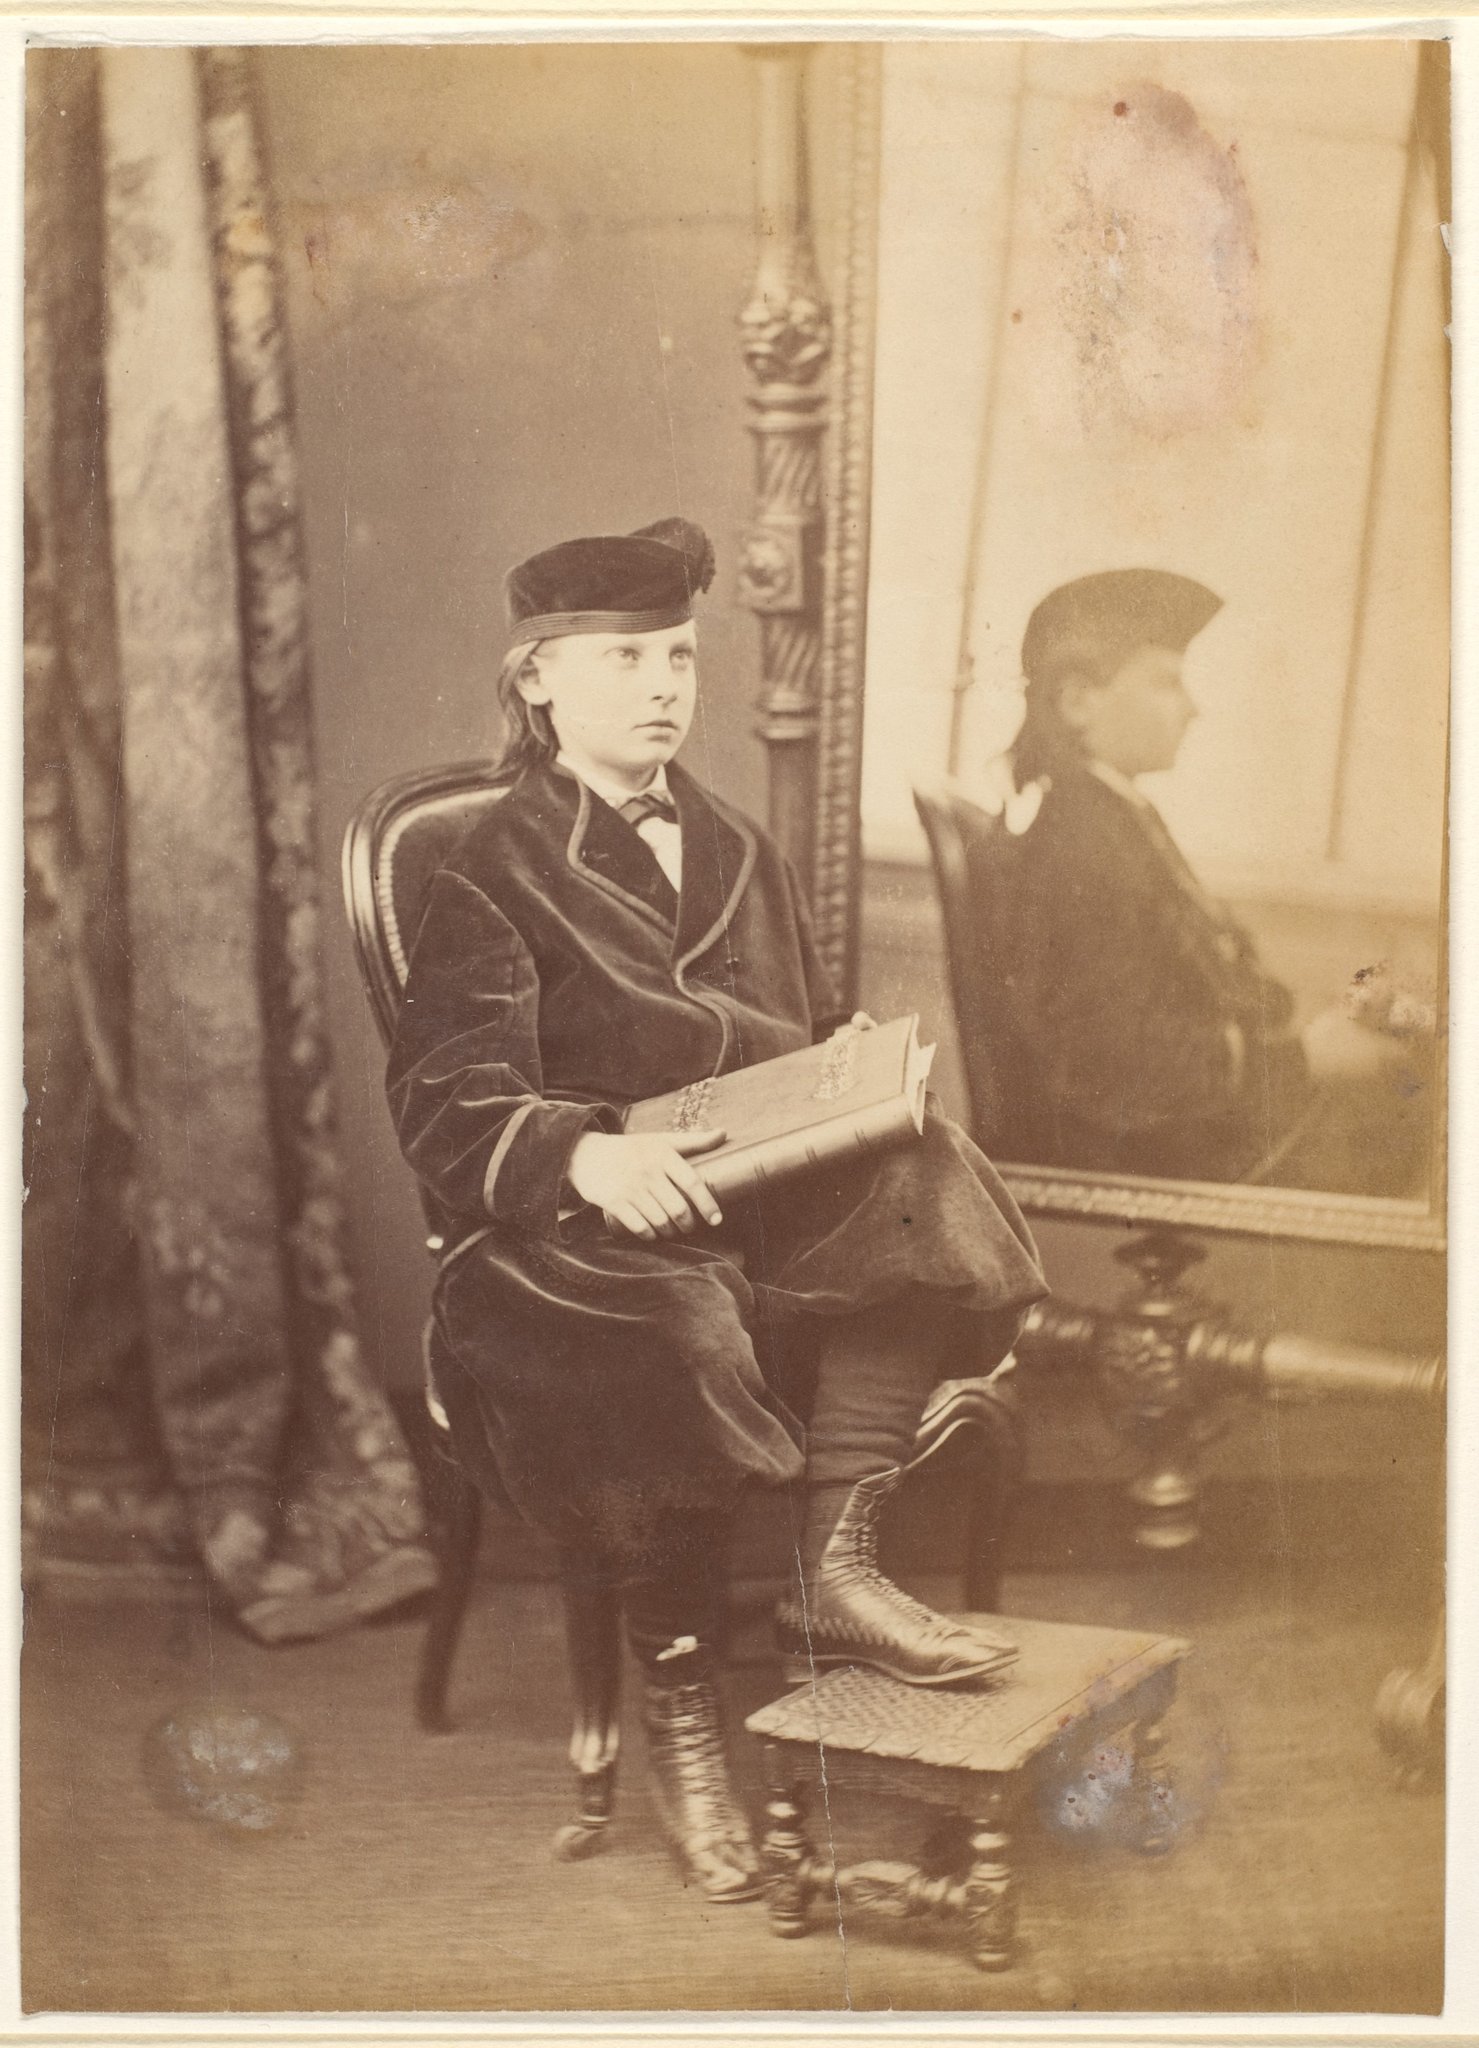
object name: photograph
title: Le petit Russe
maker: pierre-louis pierson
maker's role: artist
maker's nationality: french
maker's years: 1822-1913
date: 1860-1869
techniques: albumen silver print, glass negative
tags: books,boys,mirrors